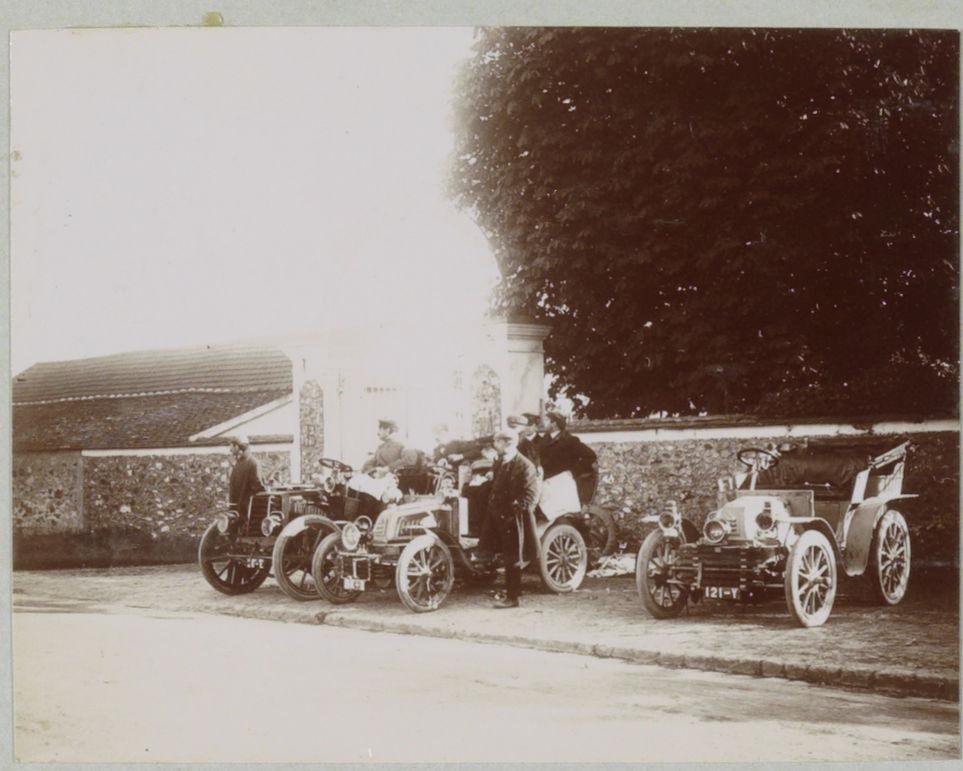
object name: photograph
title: Toeschouwers bij de automobielrace Parijs-Vienne bij hun op een stoep geparkeerde voertuigen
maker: delizy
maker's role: manufacturer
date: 1902-1906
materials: paper, photographic support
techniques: gelatin silver print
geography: france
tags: maintenance, repair, storage ~ motor vehicles, motorcar racing, automobile, france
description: Onderdeel van Fotoalbum van een Franse amateurfotograaf met opnames van uitstapjes in Frankrijk, Spanje, België, Luxemburg en Nederland, de eerste automobielen en autoraces.